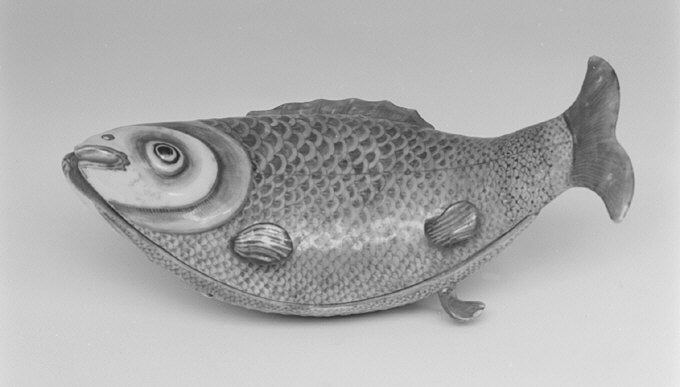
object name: dish with cover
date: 1750-1770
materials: hard paste porcelain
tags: fish